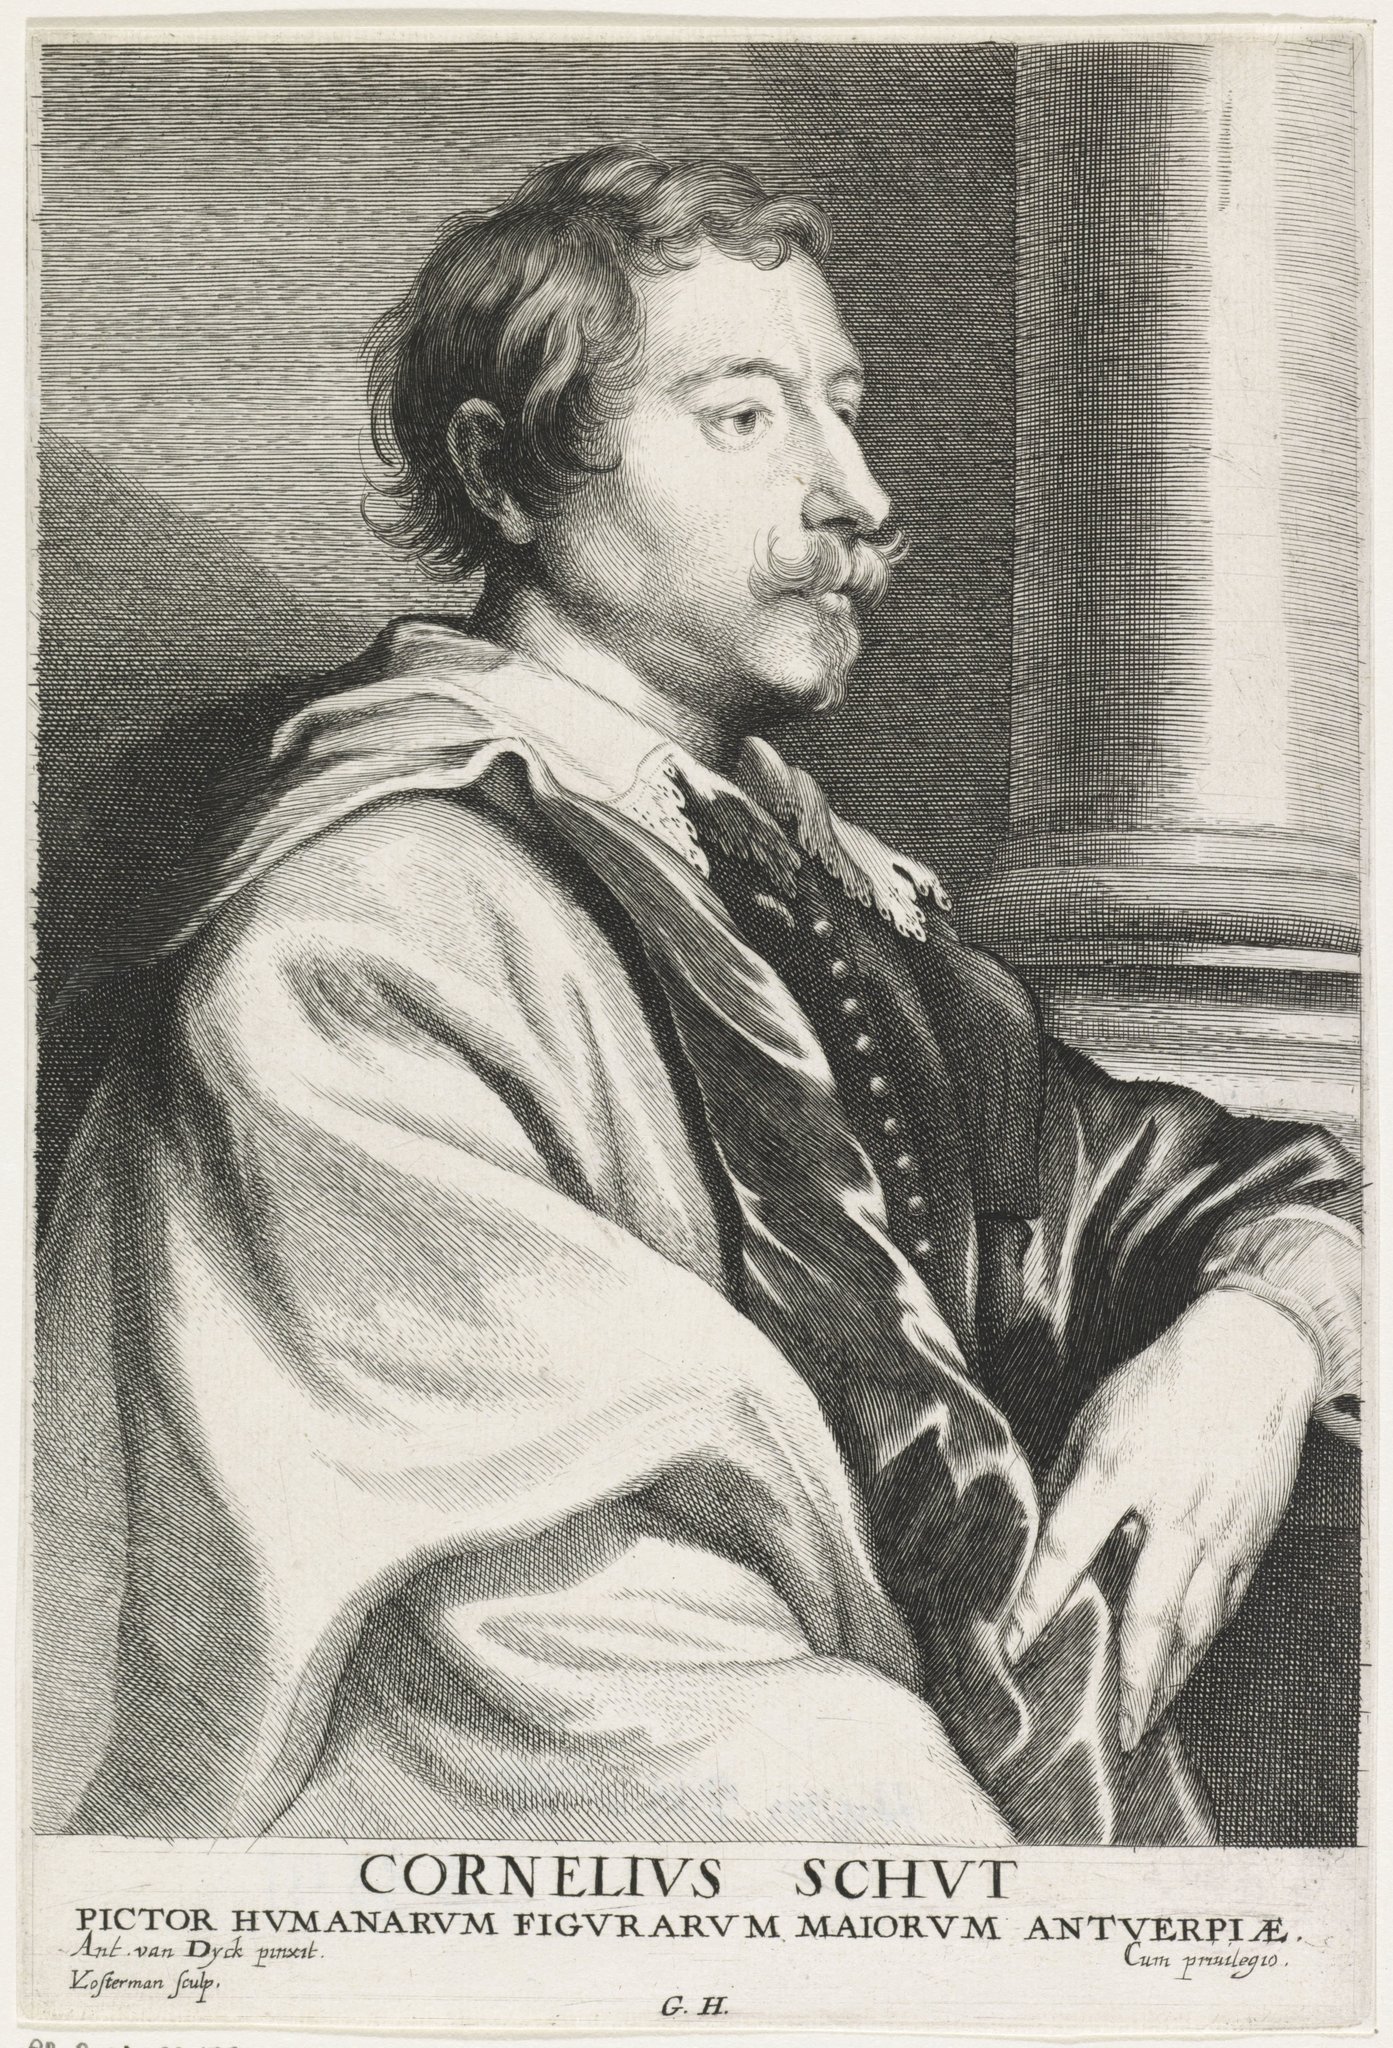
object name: print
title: Iconographie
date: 1645-1646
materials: paper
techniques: engraving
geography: antwerp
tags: antwerp, print maker, draughtsman, cornelis schut (i)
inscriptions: collector's mark: Lugt 240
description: Prent gebruikt voor: Icones principum, virorum doctorum, pictorum, chalcographorum, statuariorum nec non amatorum pictoriae artis numero centum ab Ant. van Dyck ad vivum expressae ejusque sumptibus aeri incisae. Antwerpen: Gillis Hendricx, [1645-1646].